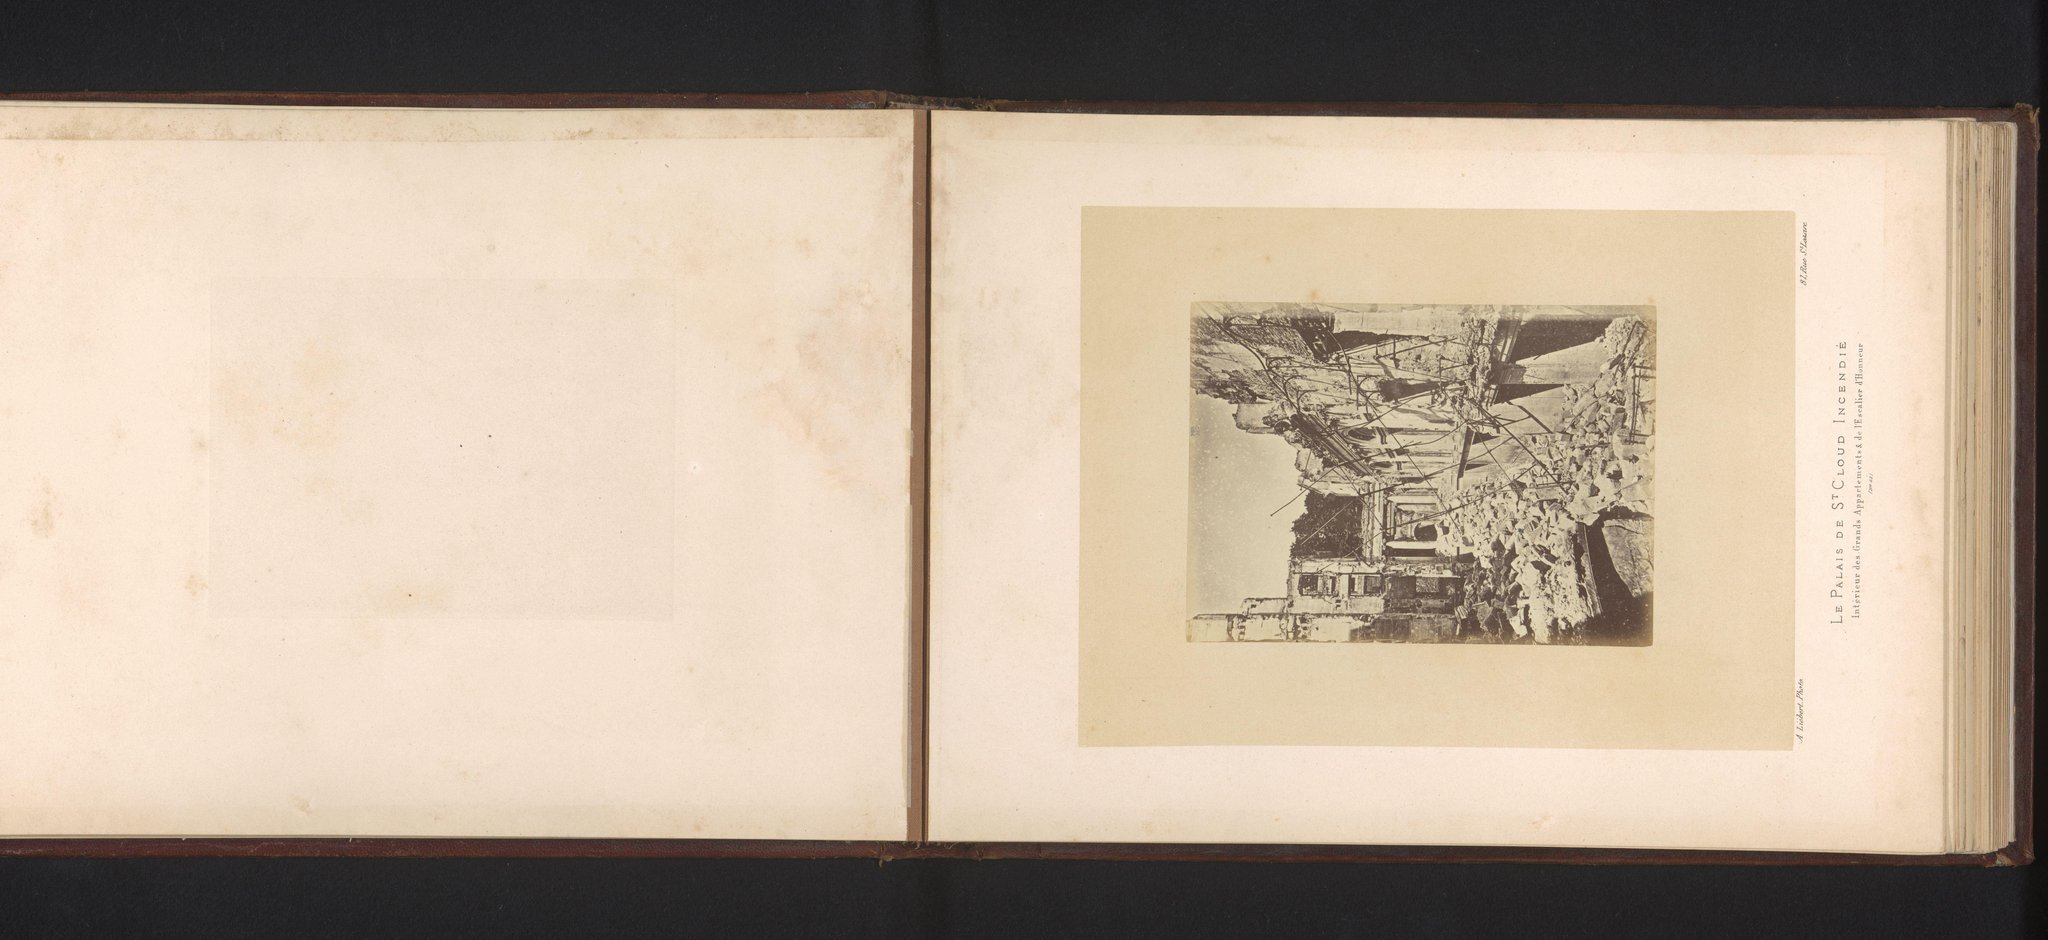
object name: page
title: Le Palais de St. Cloud Incendié. Intérieur des Grands Appartements & de l'Escalier d'Honneur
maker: alphonse-justin liébert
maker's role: fotograaf, marinier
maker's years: 1827-1914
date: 1871-1872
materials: photographic support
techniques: albumen print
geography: saint-cloud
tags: stairwell, castle, ruin of a building ~ architecture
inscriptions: address: ‘31, Rue St. Lazare’, number: ‘(No. 61)’